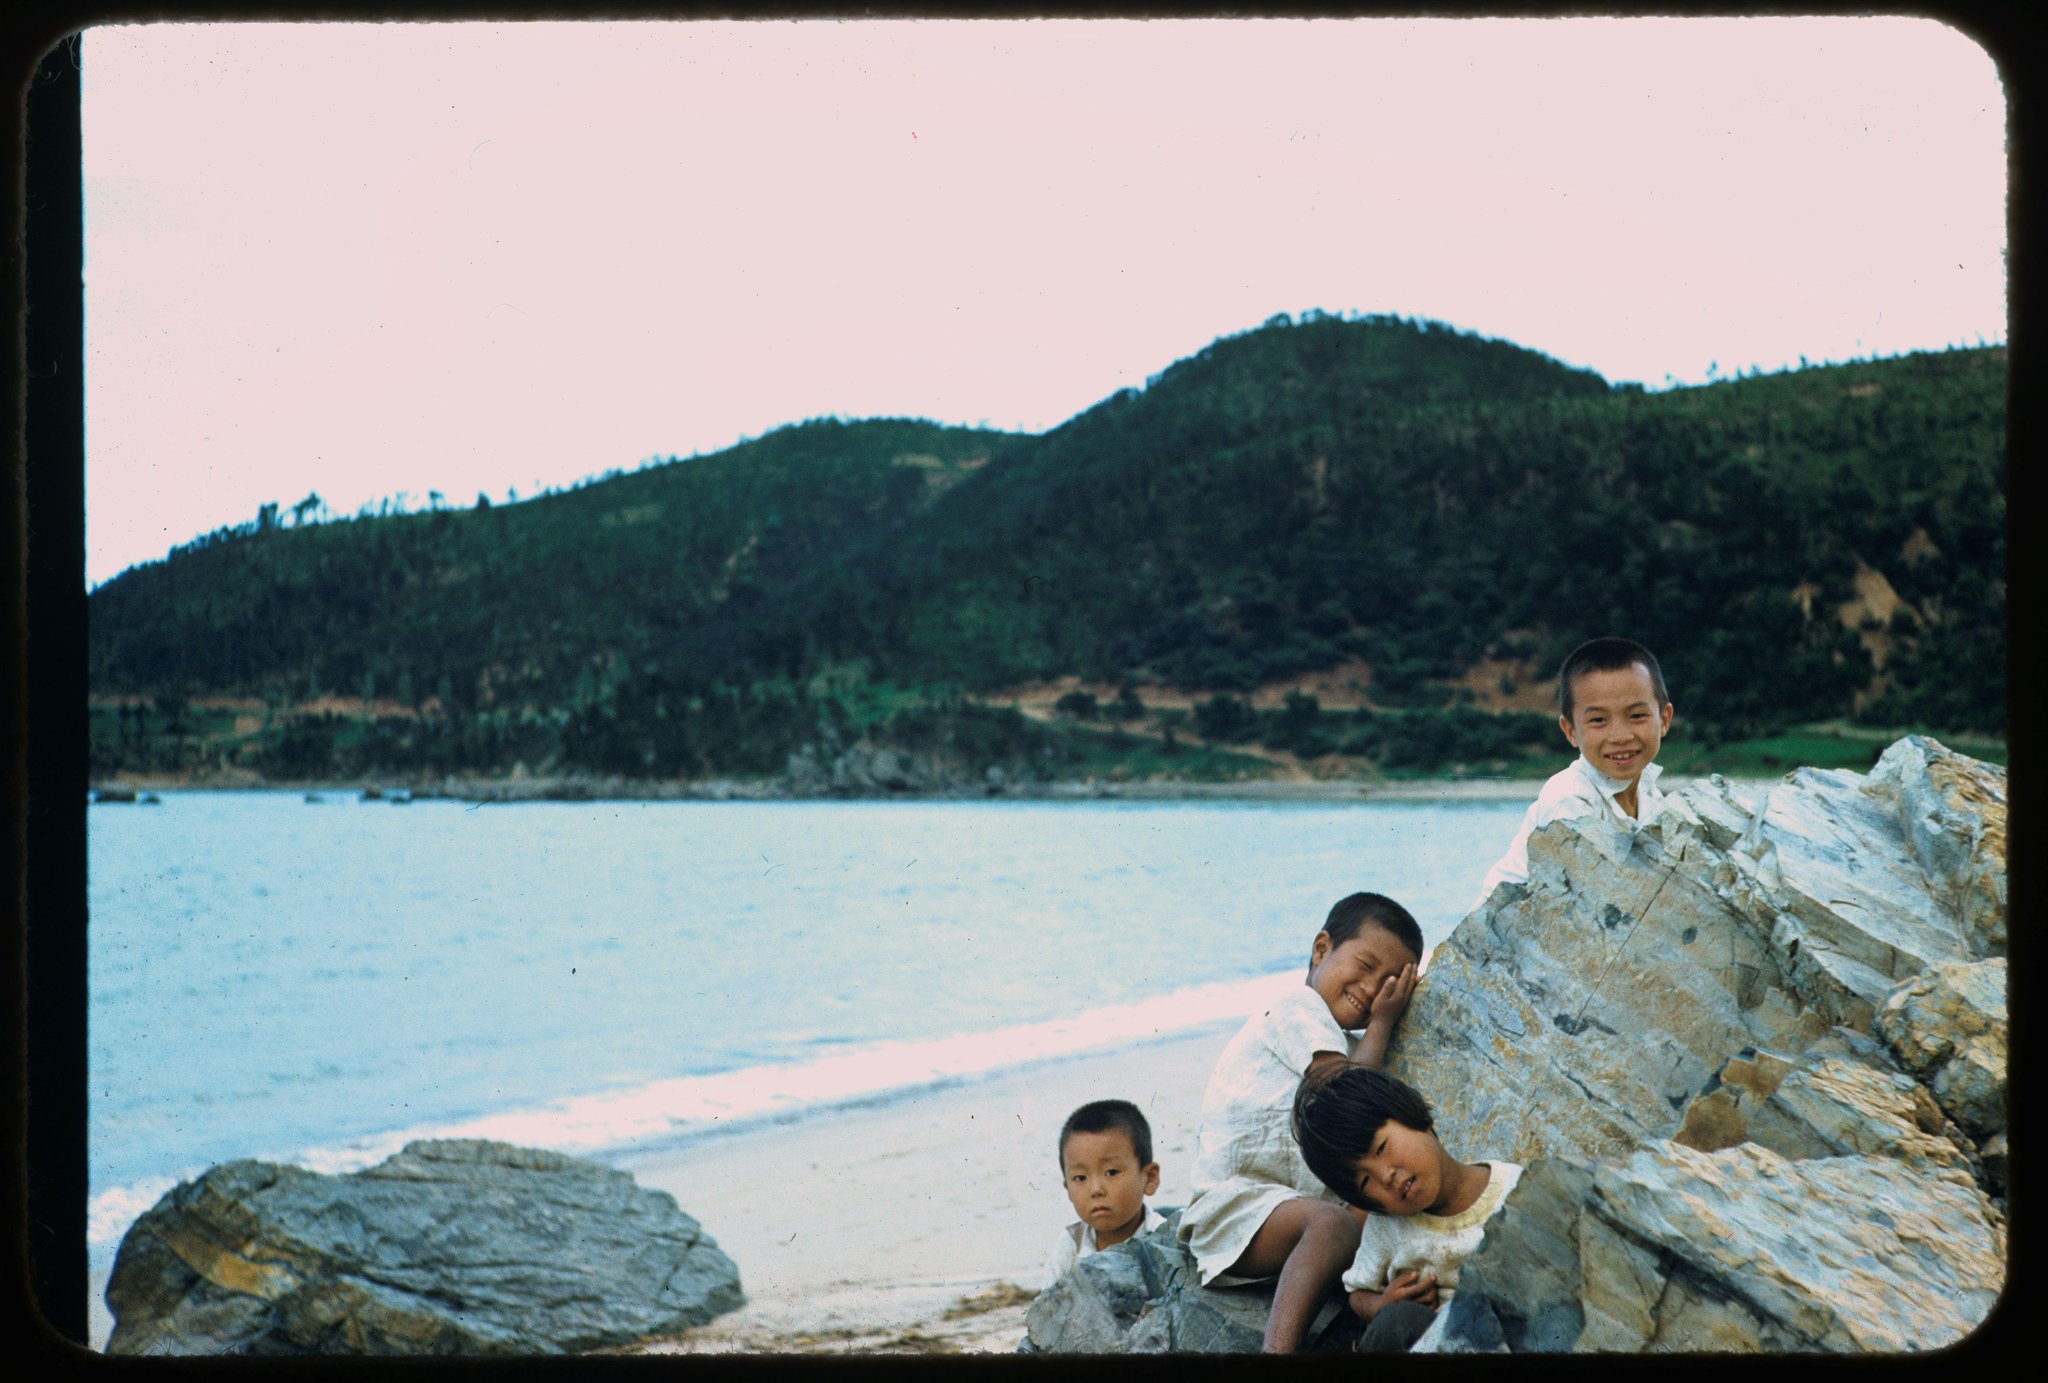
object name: color slide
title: Oorlog in Korea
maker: david ketel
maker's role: diplomaat, sinoloog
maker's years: 1913-2008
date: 1952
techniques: slide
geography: korea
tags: united nations